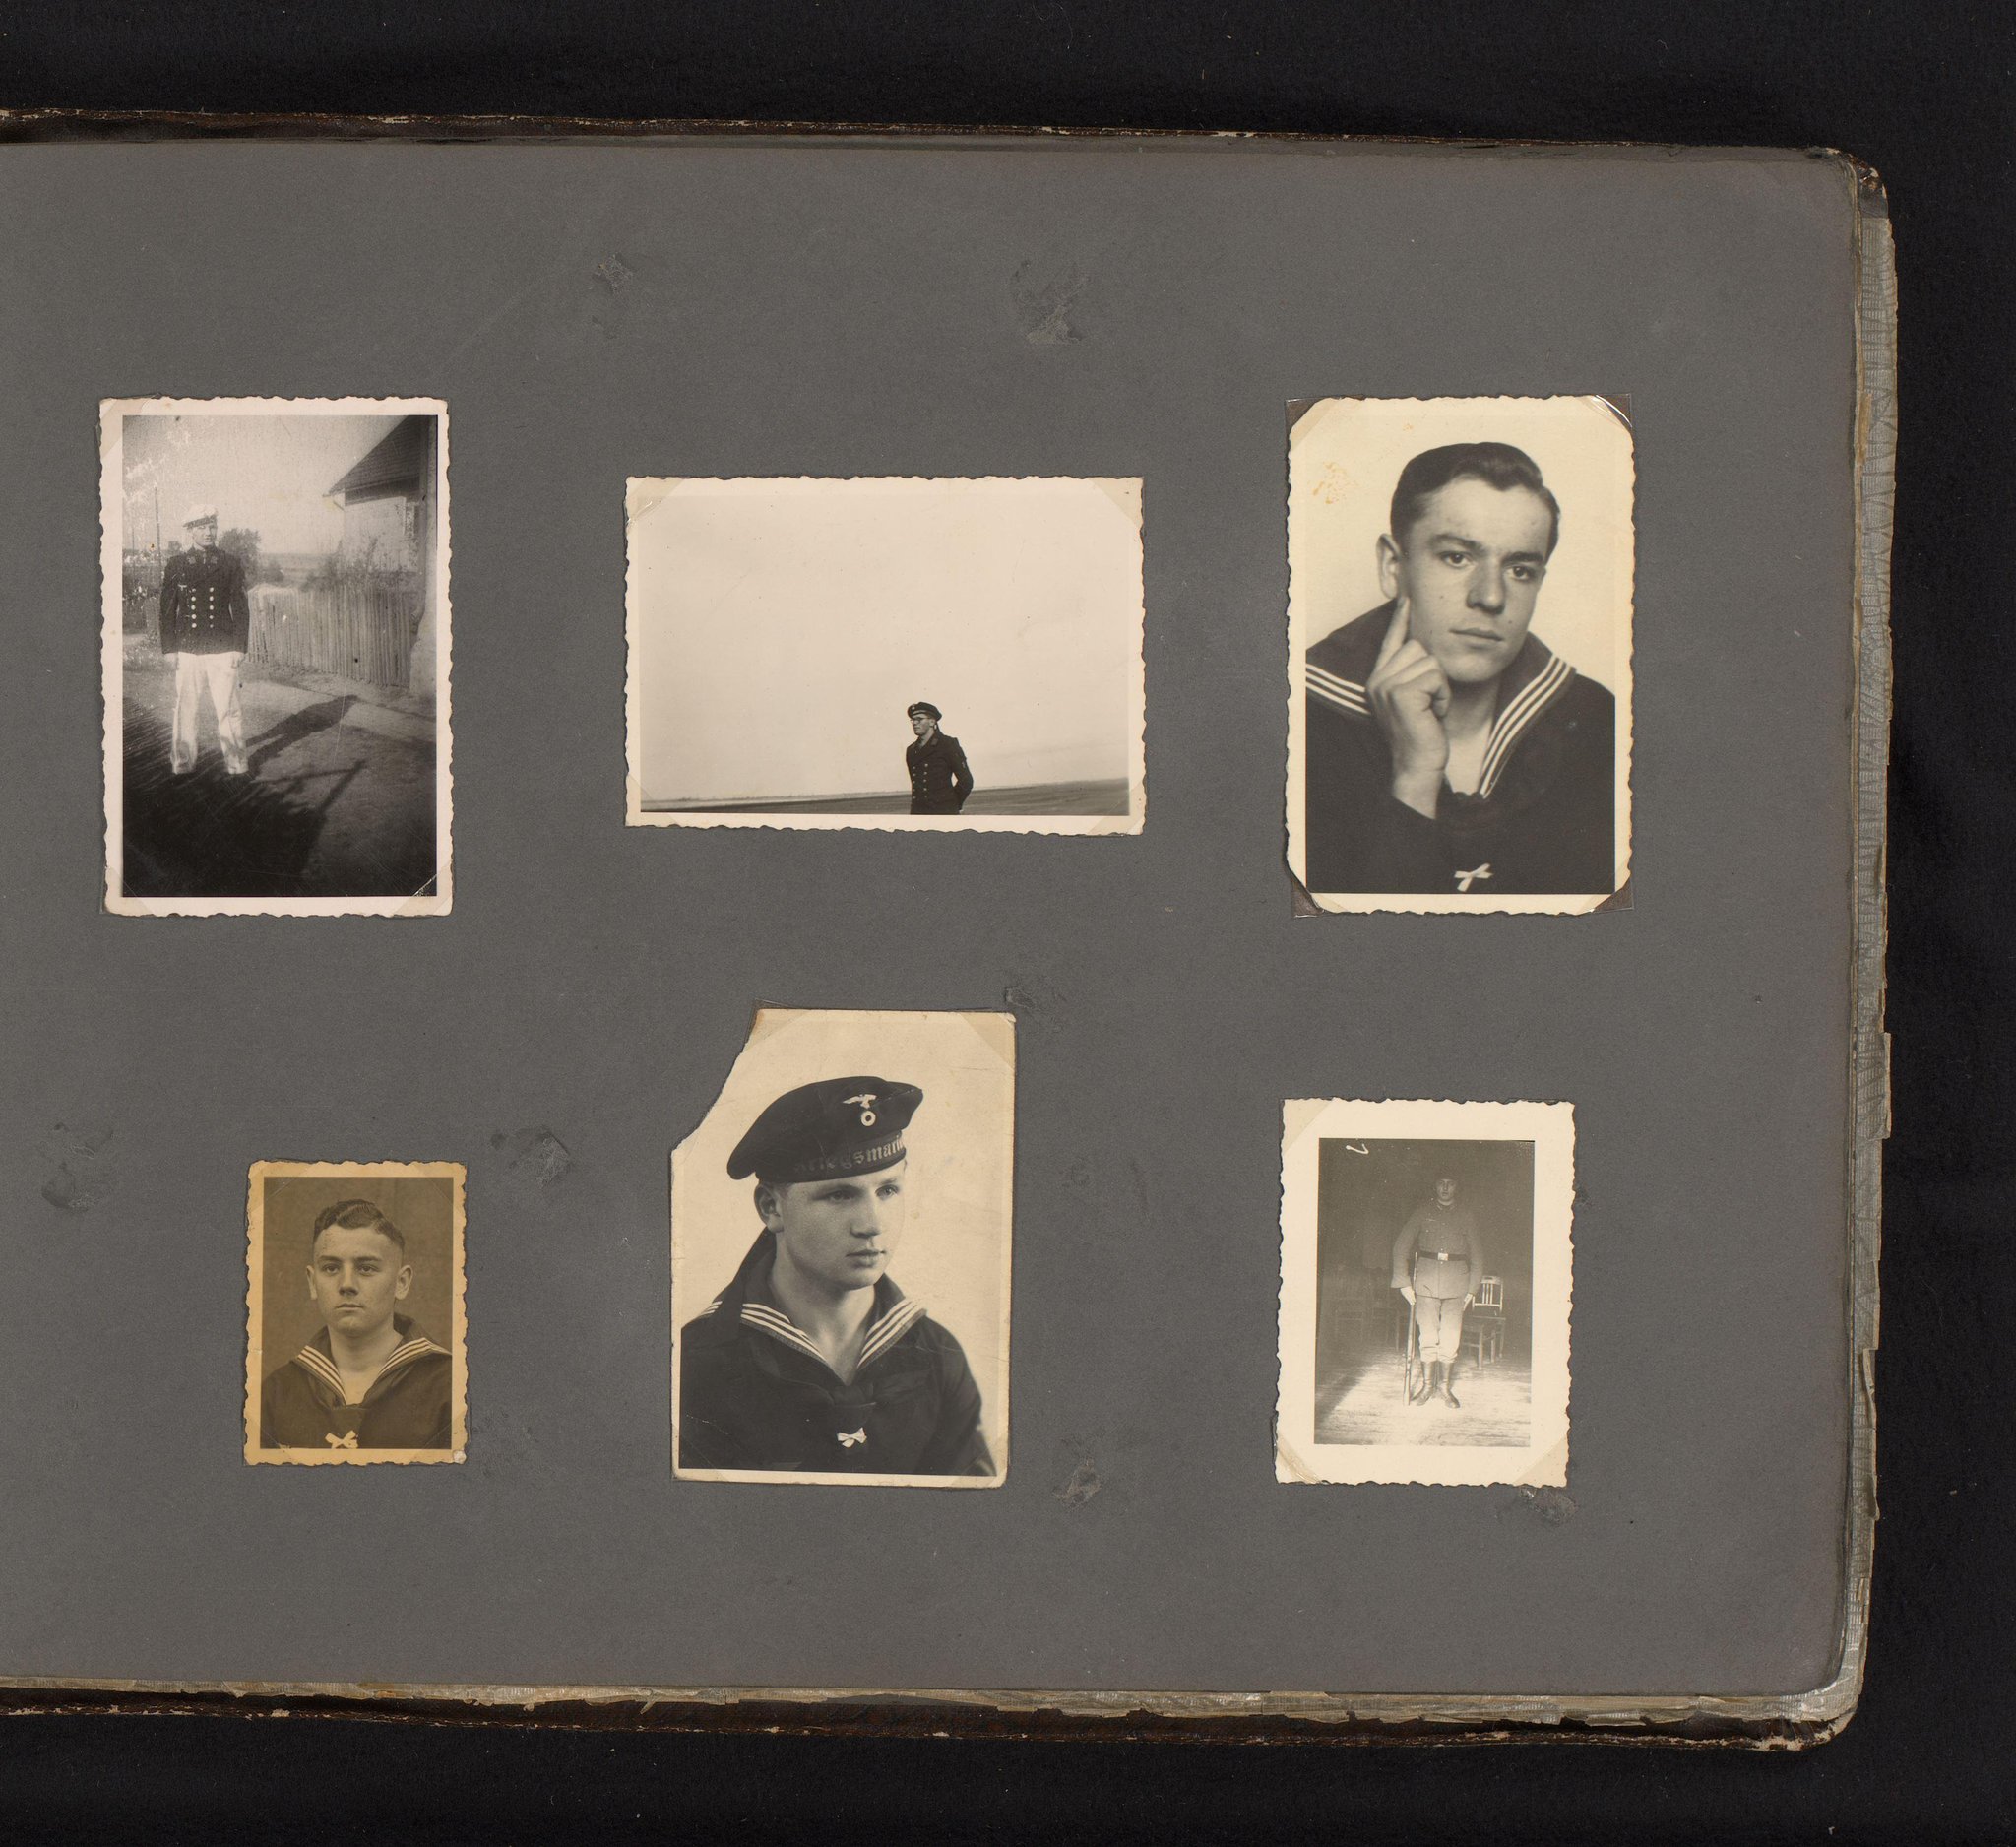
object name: photograph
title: Portretten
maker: Anonymous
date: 1941-1943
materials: paper, photographic support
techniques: gelatin silver print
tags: reinhold mohr, the company, the unit, the troop ~ military service, sailor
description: Albumblad met zes foto's met portretten van de samensteller en andere matrozen. Onderdeel van het fotoalbum Kriegsmarine.